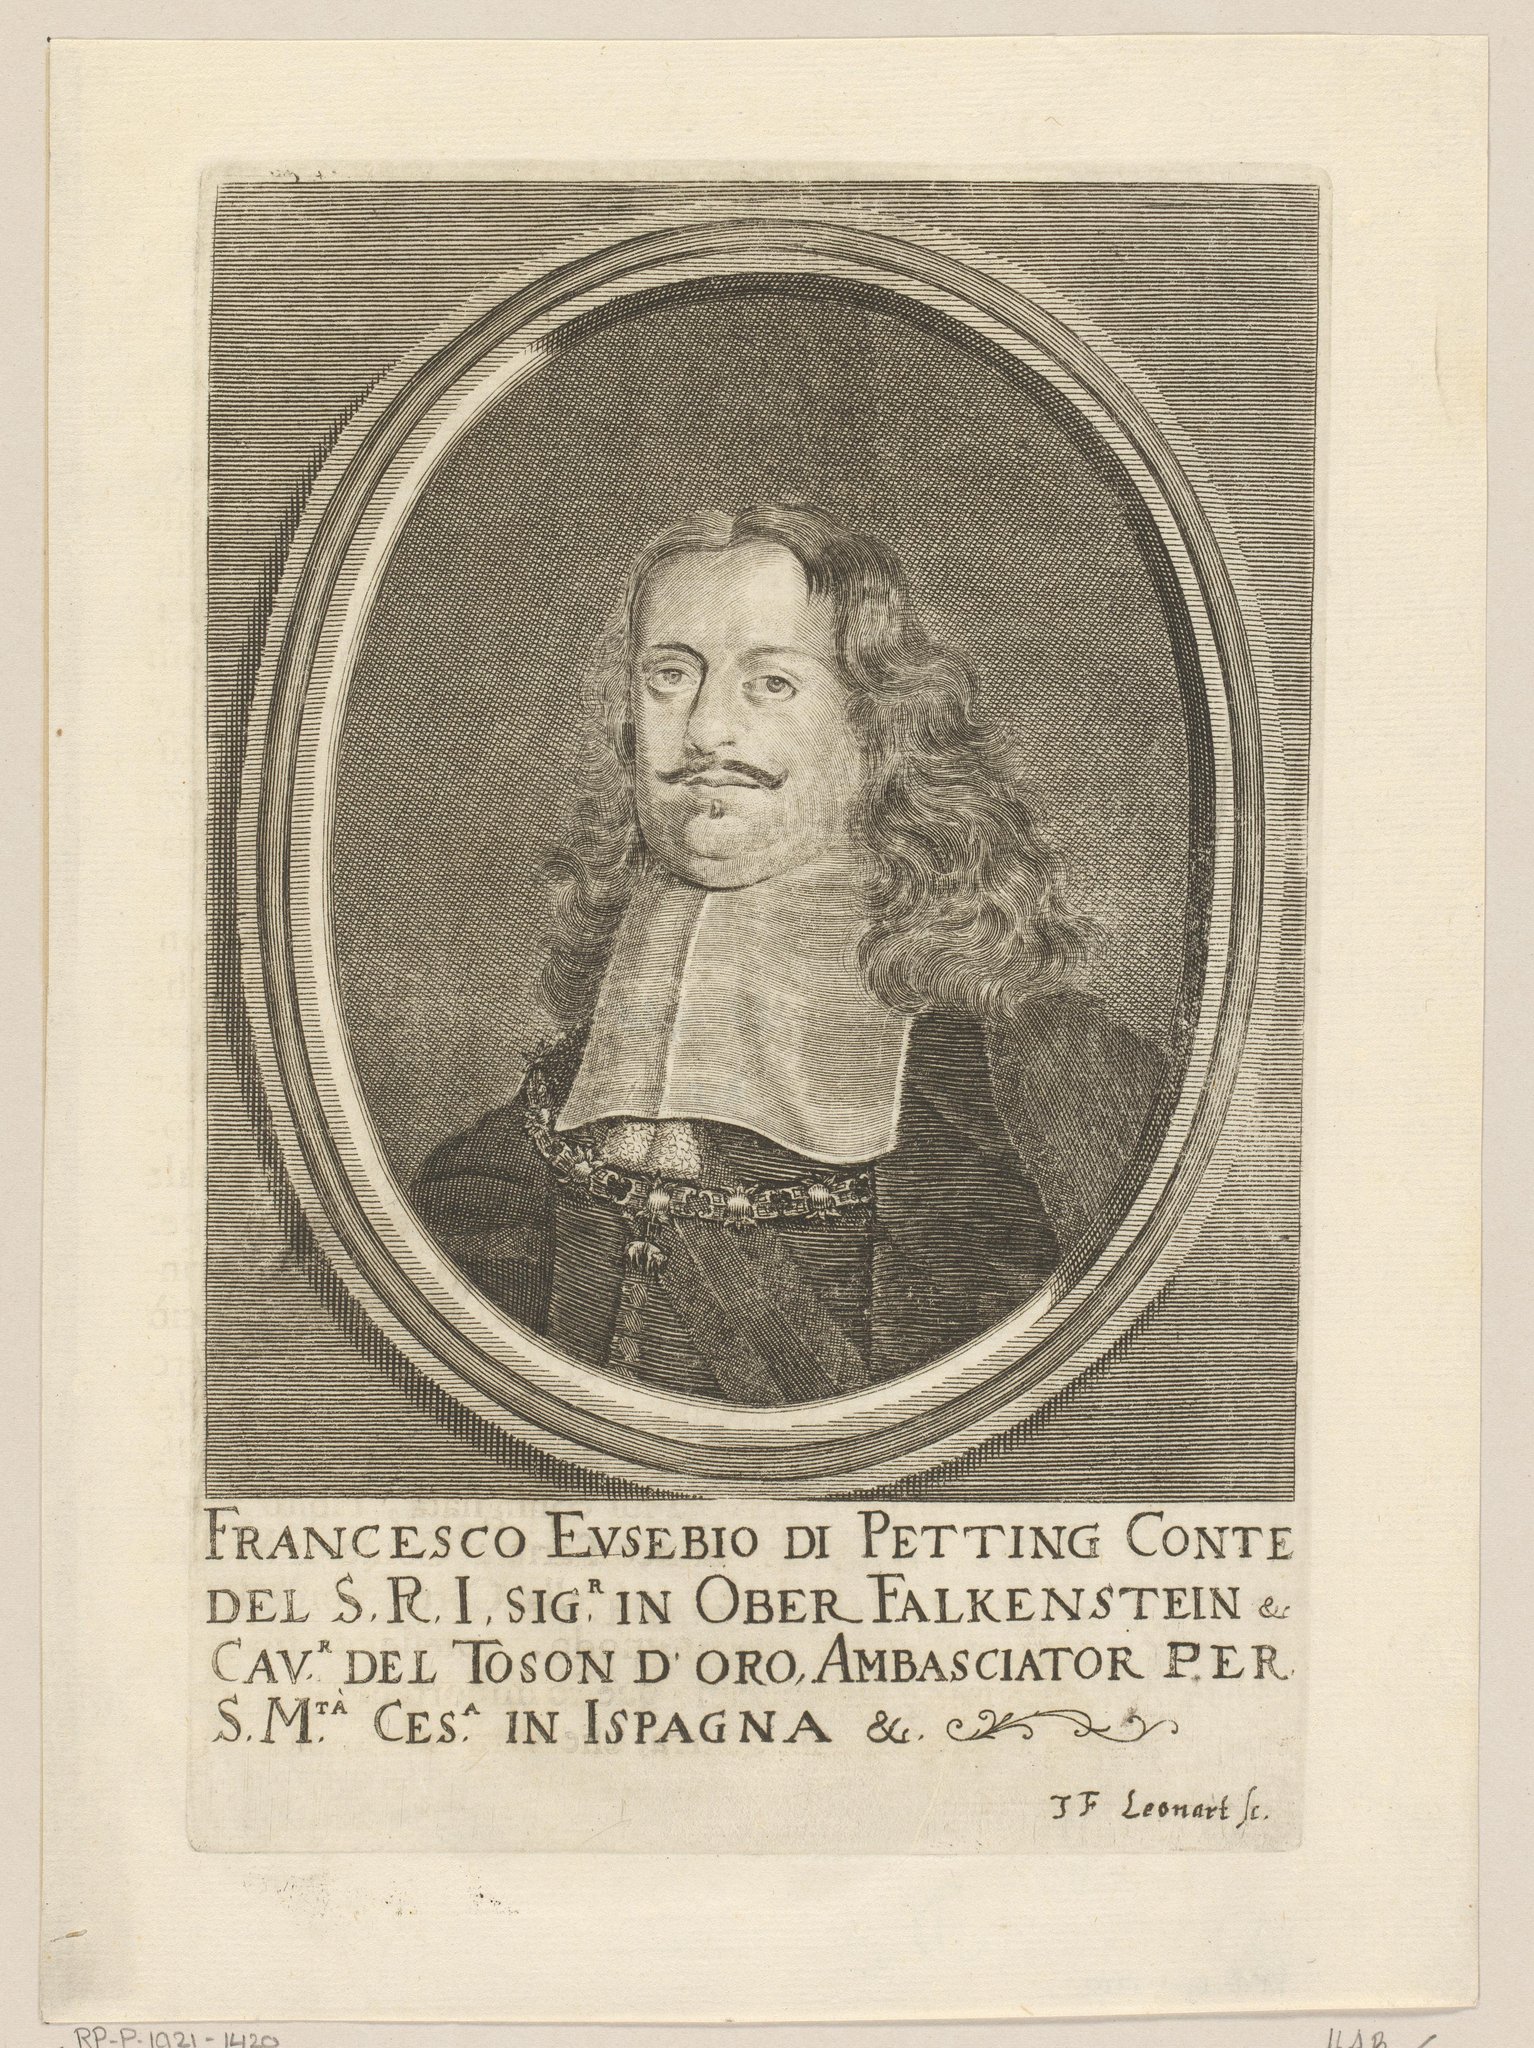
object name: print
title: Portret van Franz Eusebius von Pötting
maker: johann friedrich leonard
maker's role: print maker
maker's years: 1633-1680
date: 1643-1680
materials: paper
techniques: engraving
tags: historical persons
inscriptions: collector's mark: Lugt 2233